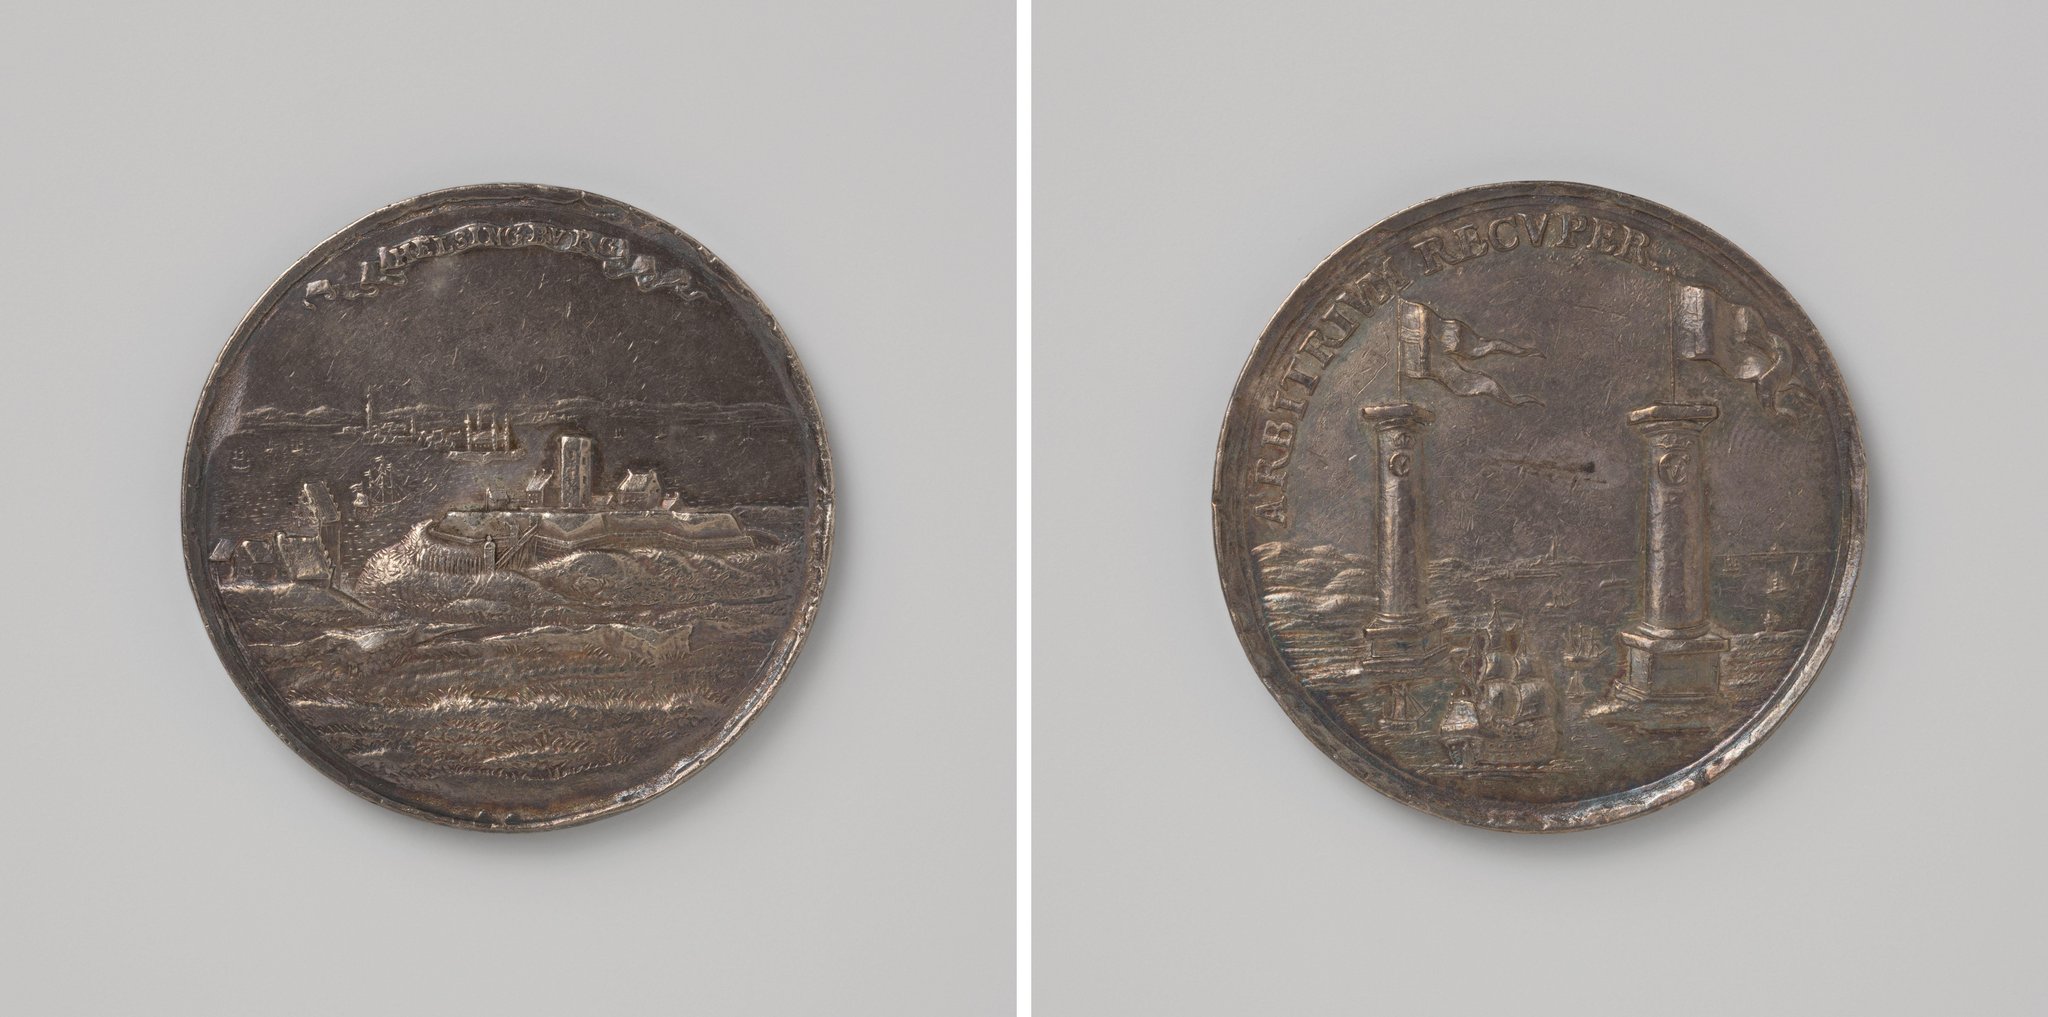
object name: history medal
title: Inname van Helsingborg door de Denen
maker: Anonymous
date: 1676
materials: silver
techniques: striking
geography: denmark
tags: zweden, helsingborg, noordse oorlogen, schonense oorlog, inname van helsingborg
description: Zilveren penning. Voorzijde: stad en vesting onder wimpel met opschrift. Keerzijde: schepen die tussen twee pilaren doorvaren met daarop gekroonde monogram van Christiaan V en Deense vlaggen binnen omschrift